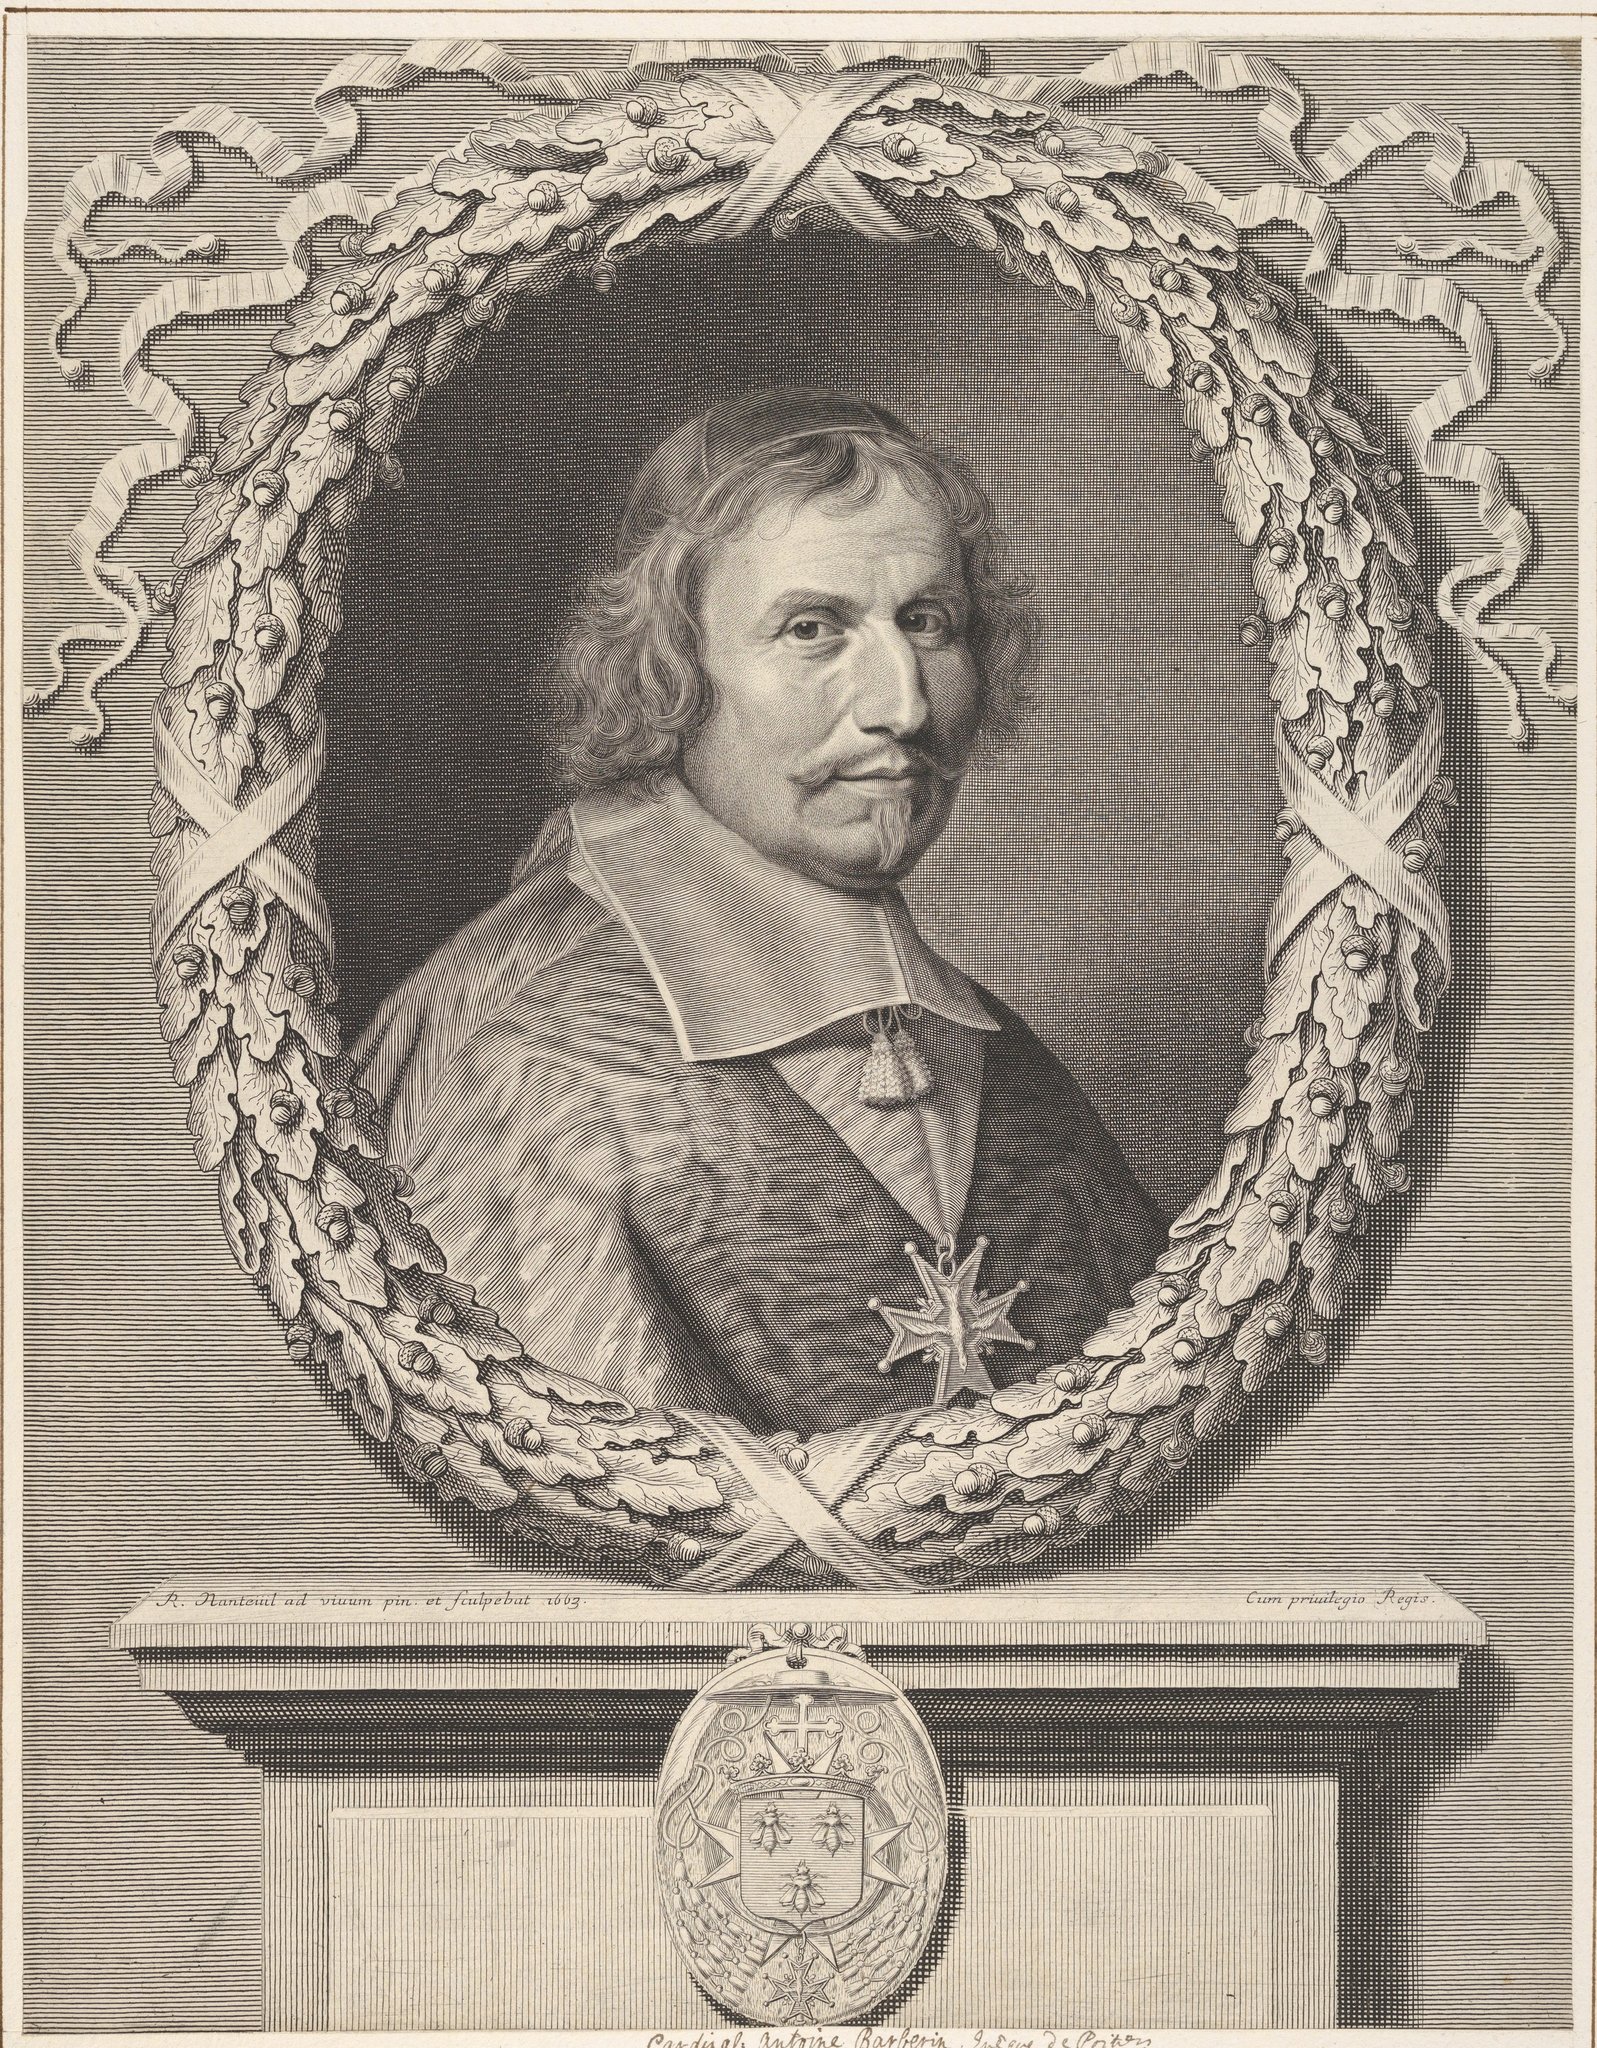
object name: print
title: Cardinal Antonio Barberini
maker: robert nanteuil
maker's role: artist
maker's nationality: french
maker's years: 1623-1678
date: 1663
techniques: engraving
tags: men,portraits,coat of arms